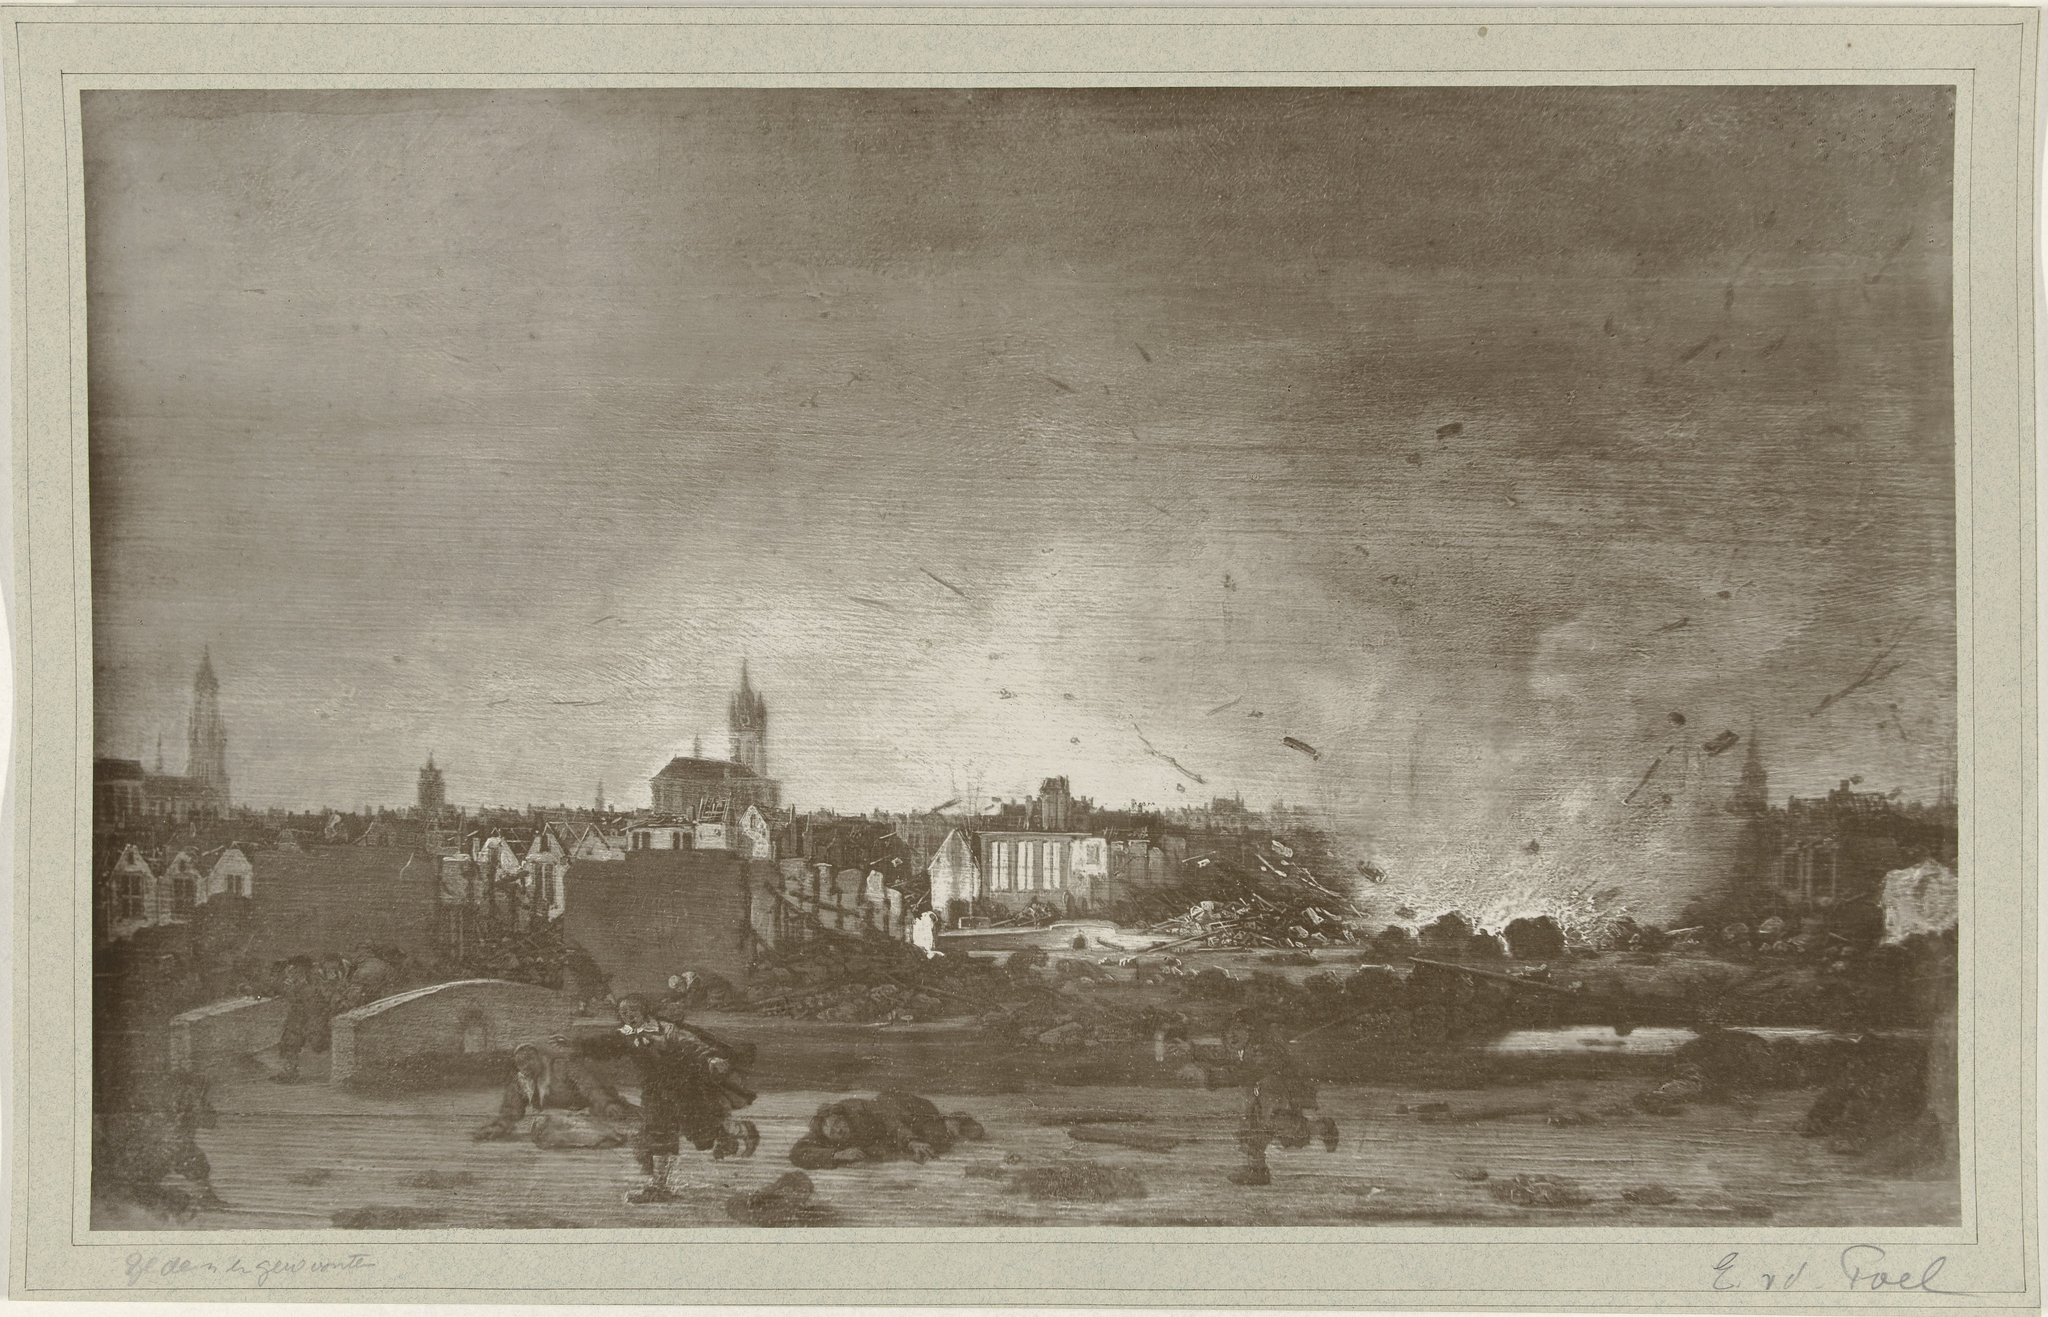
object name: photograph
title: Zeden en gewoonten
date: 1866-1900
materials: cardboard, paper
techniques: carbon print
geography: amsterdam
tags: gunpowder disaster, delft